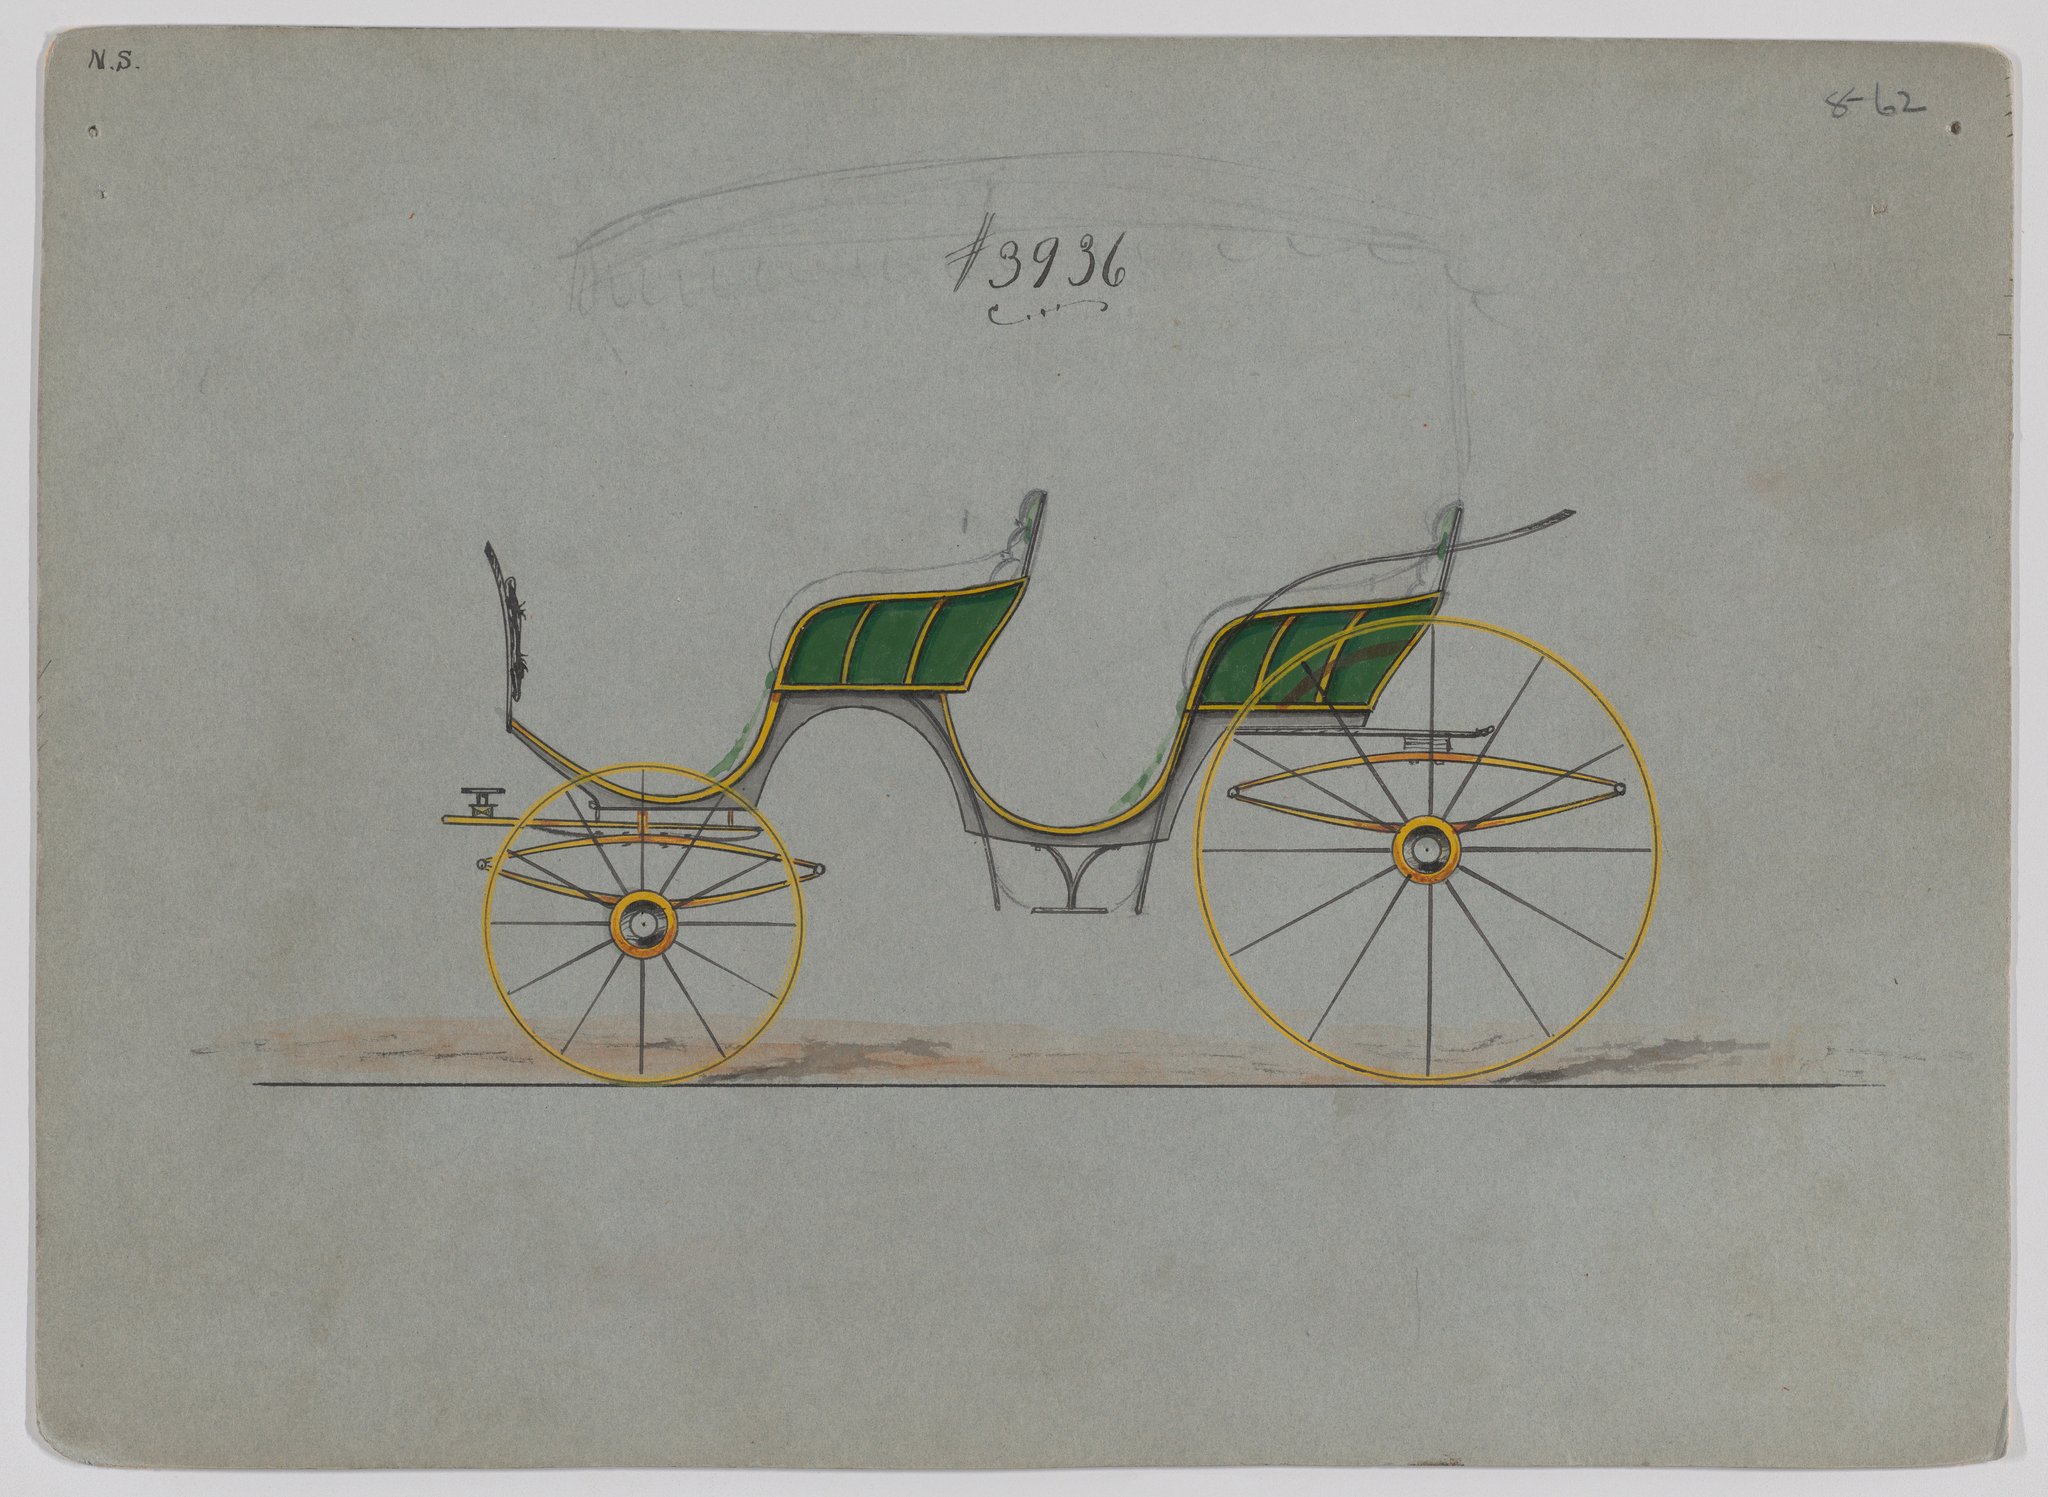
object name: drawing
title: Design for 2 seat Parasol Top Phaeton, no top, no. 3936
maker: brewster & co.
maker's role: manufacturer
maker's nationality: american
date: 1885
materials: gouache, graphite, ink, watercolor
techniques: pen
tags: carriages